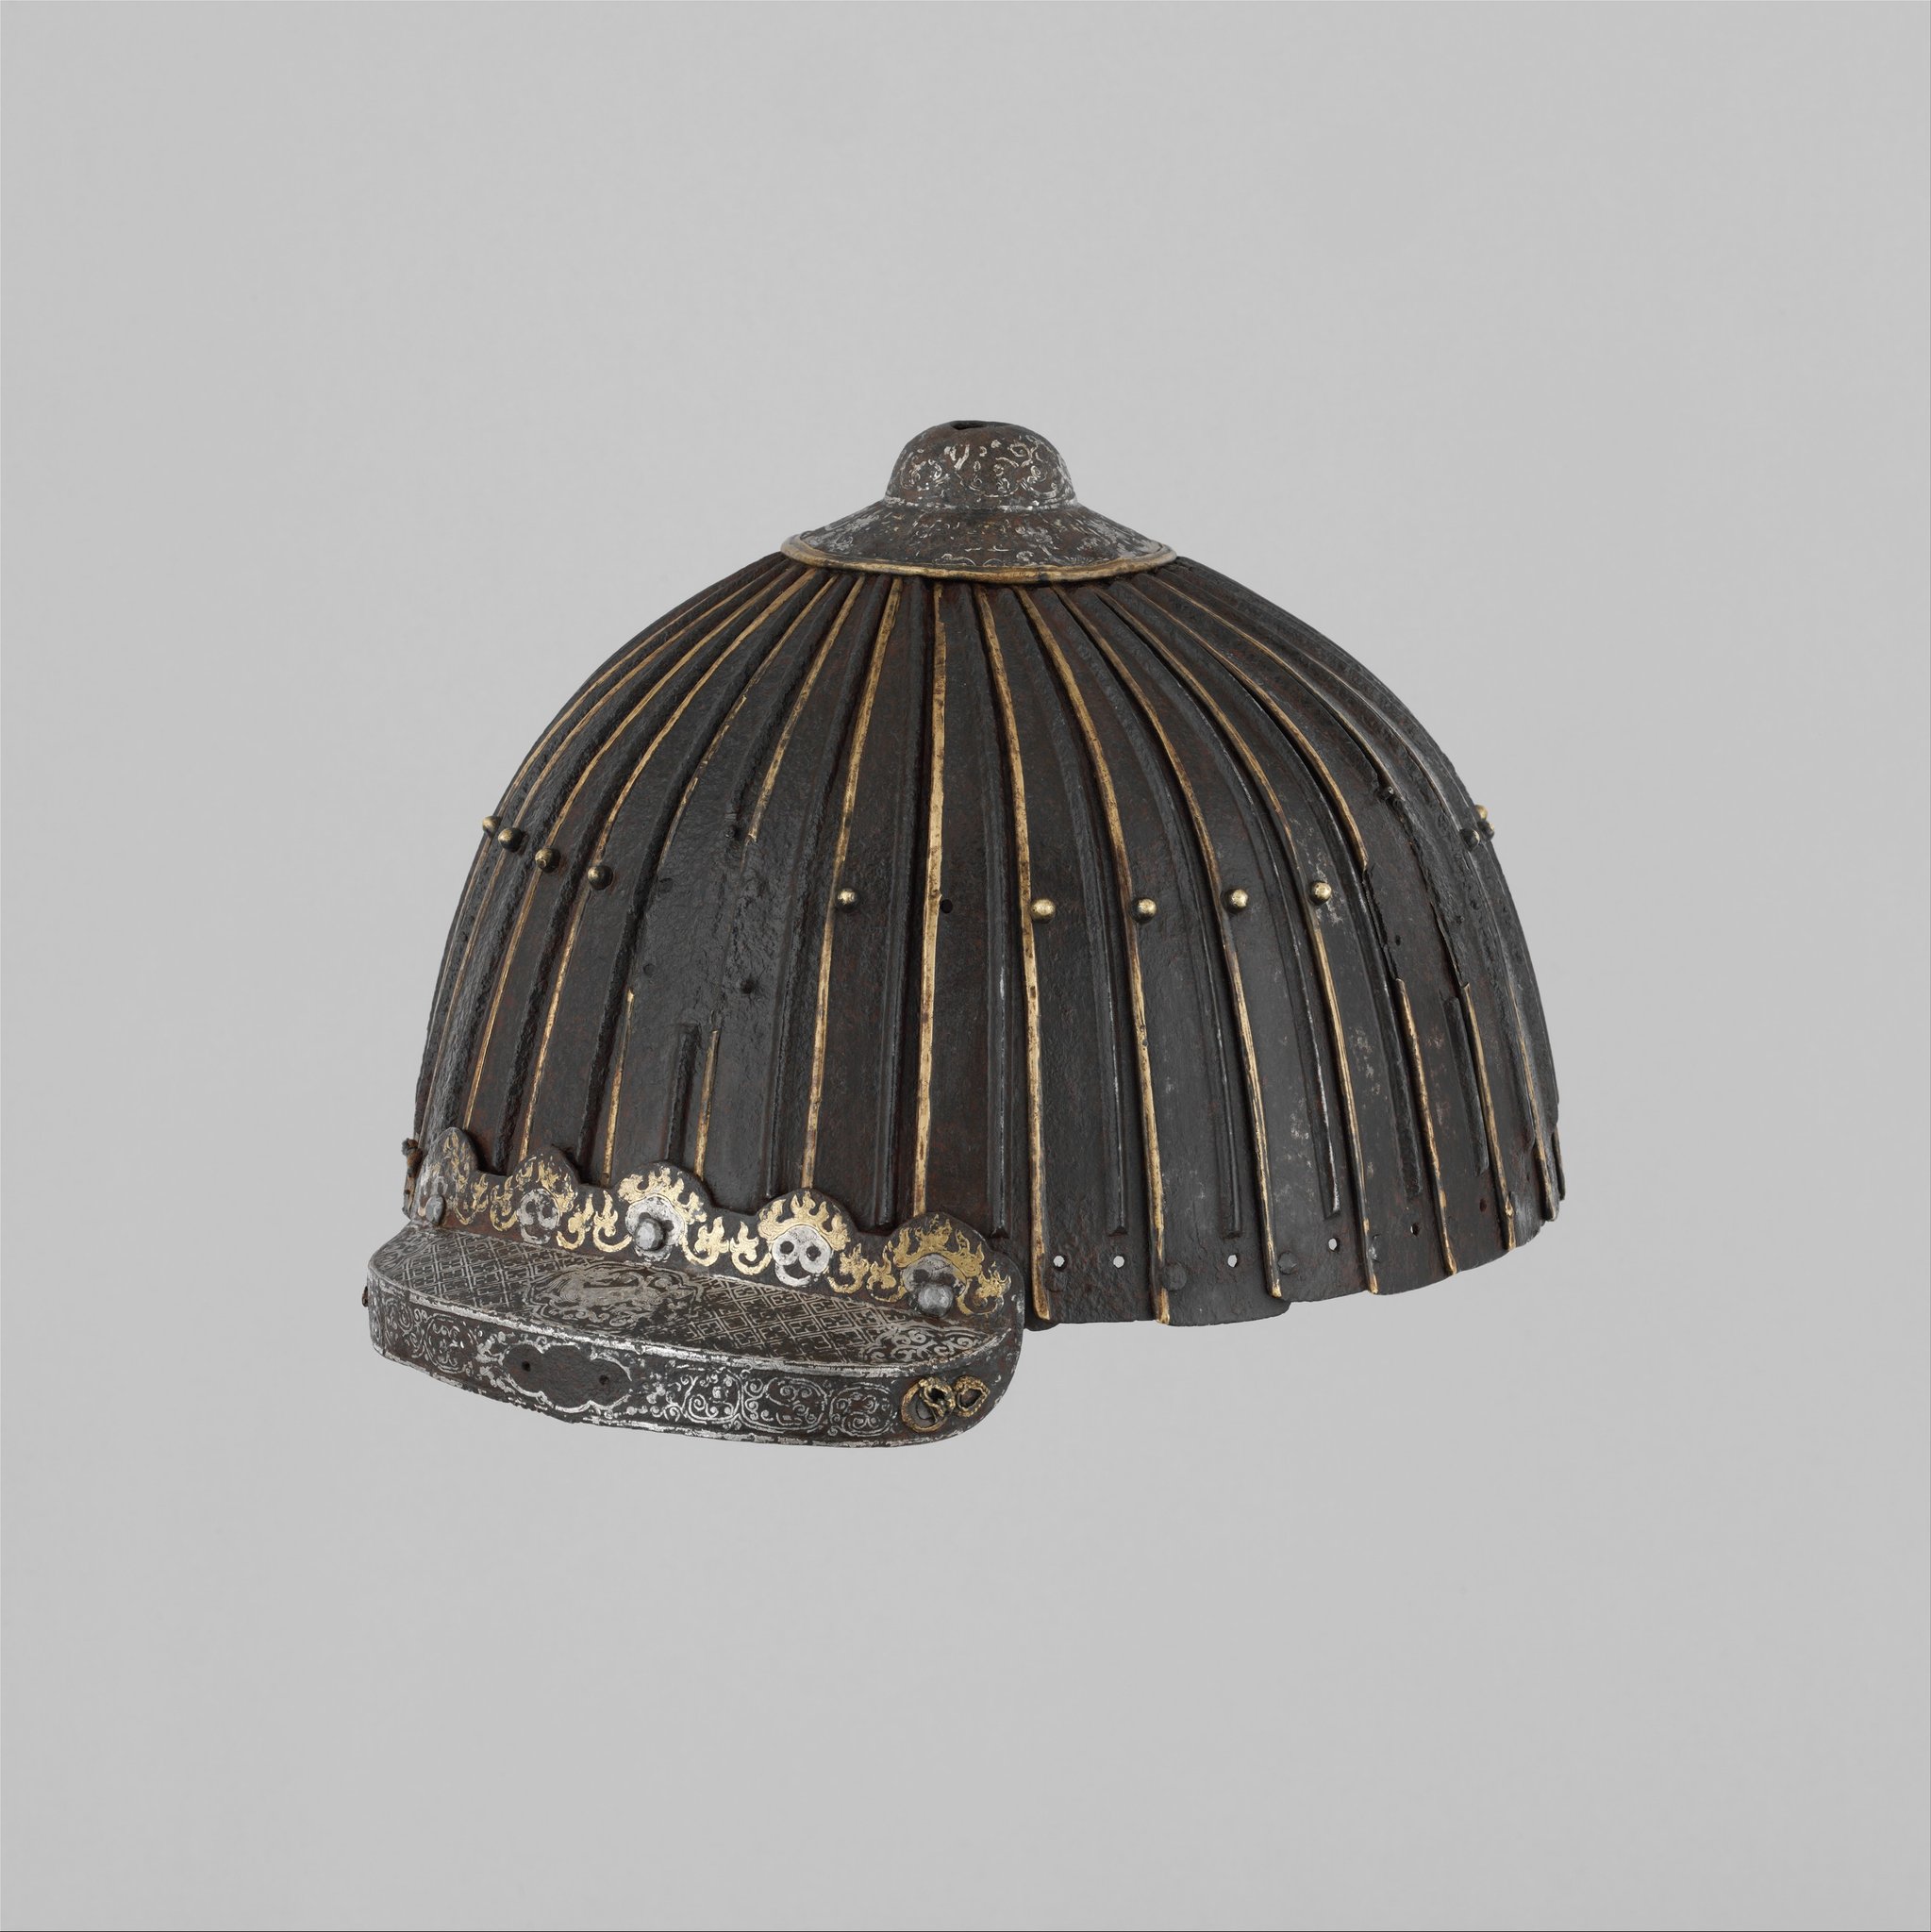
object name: helmet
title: Multi-Plate Helmet of Thirty-Two Lames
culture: mongolian or tibetan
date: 1301-1600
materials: brass, copper alloy, gold, iron, silver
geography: tibet